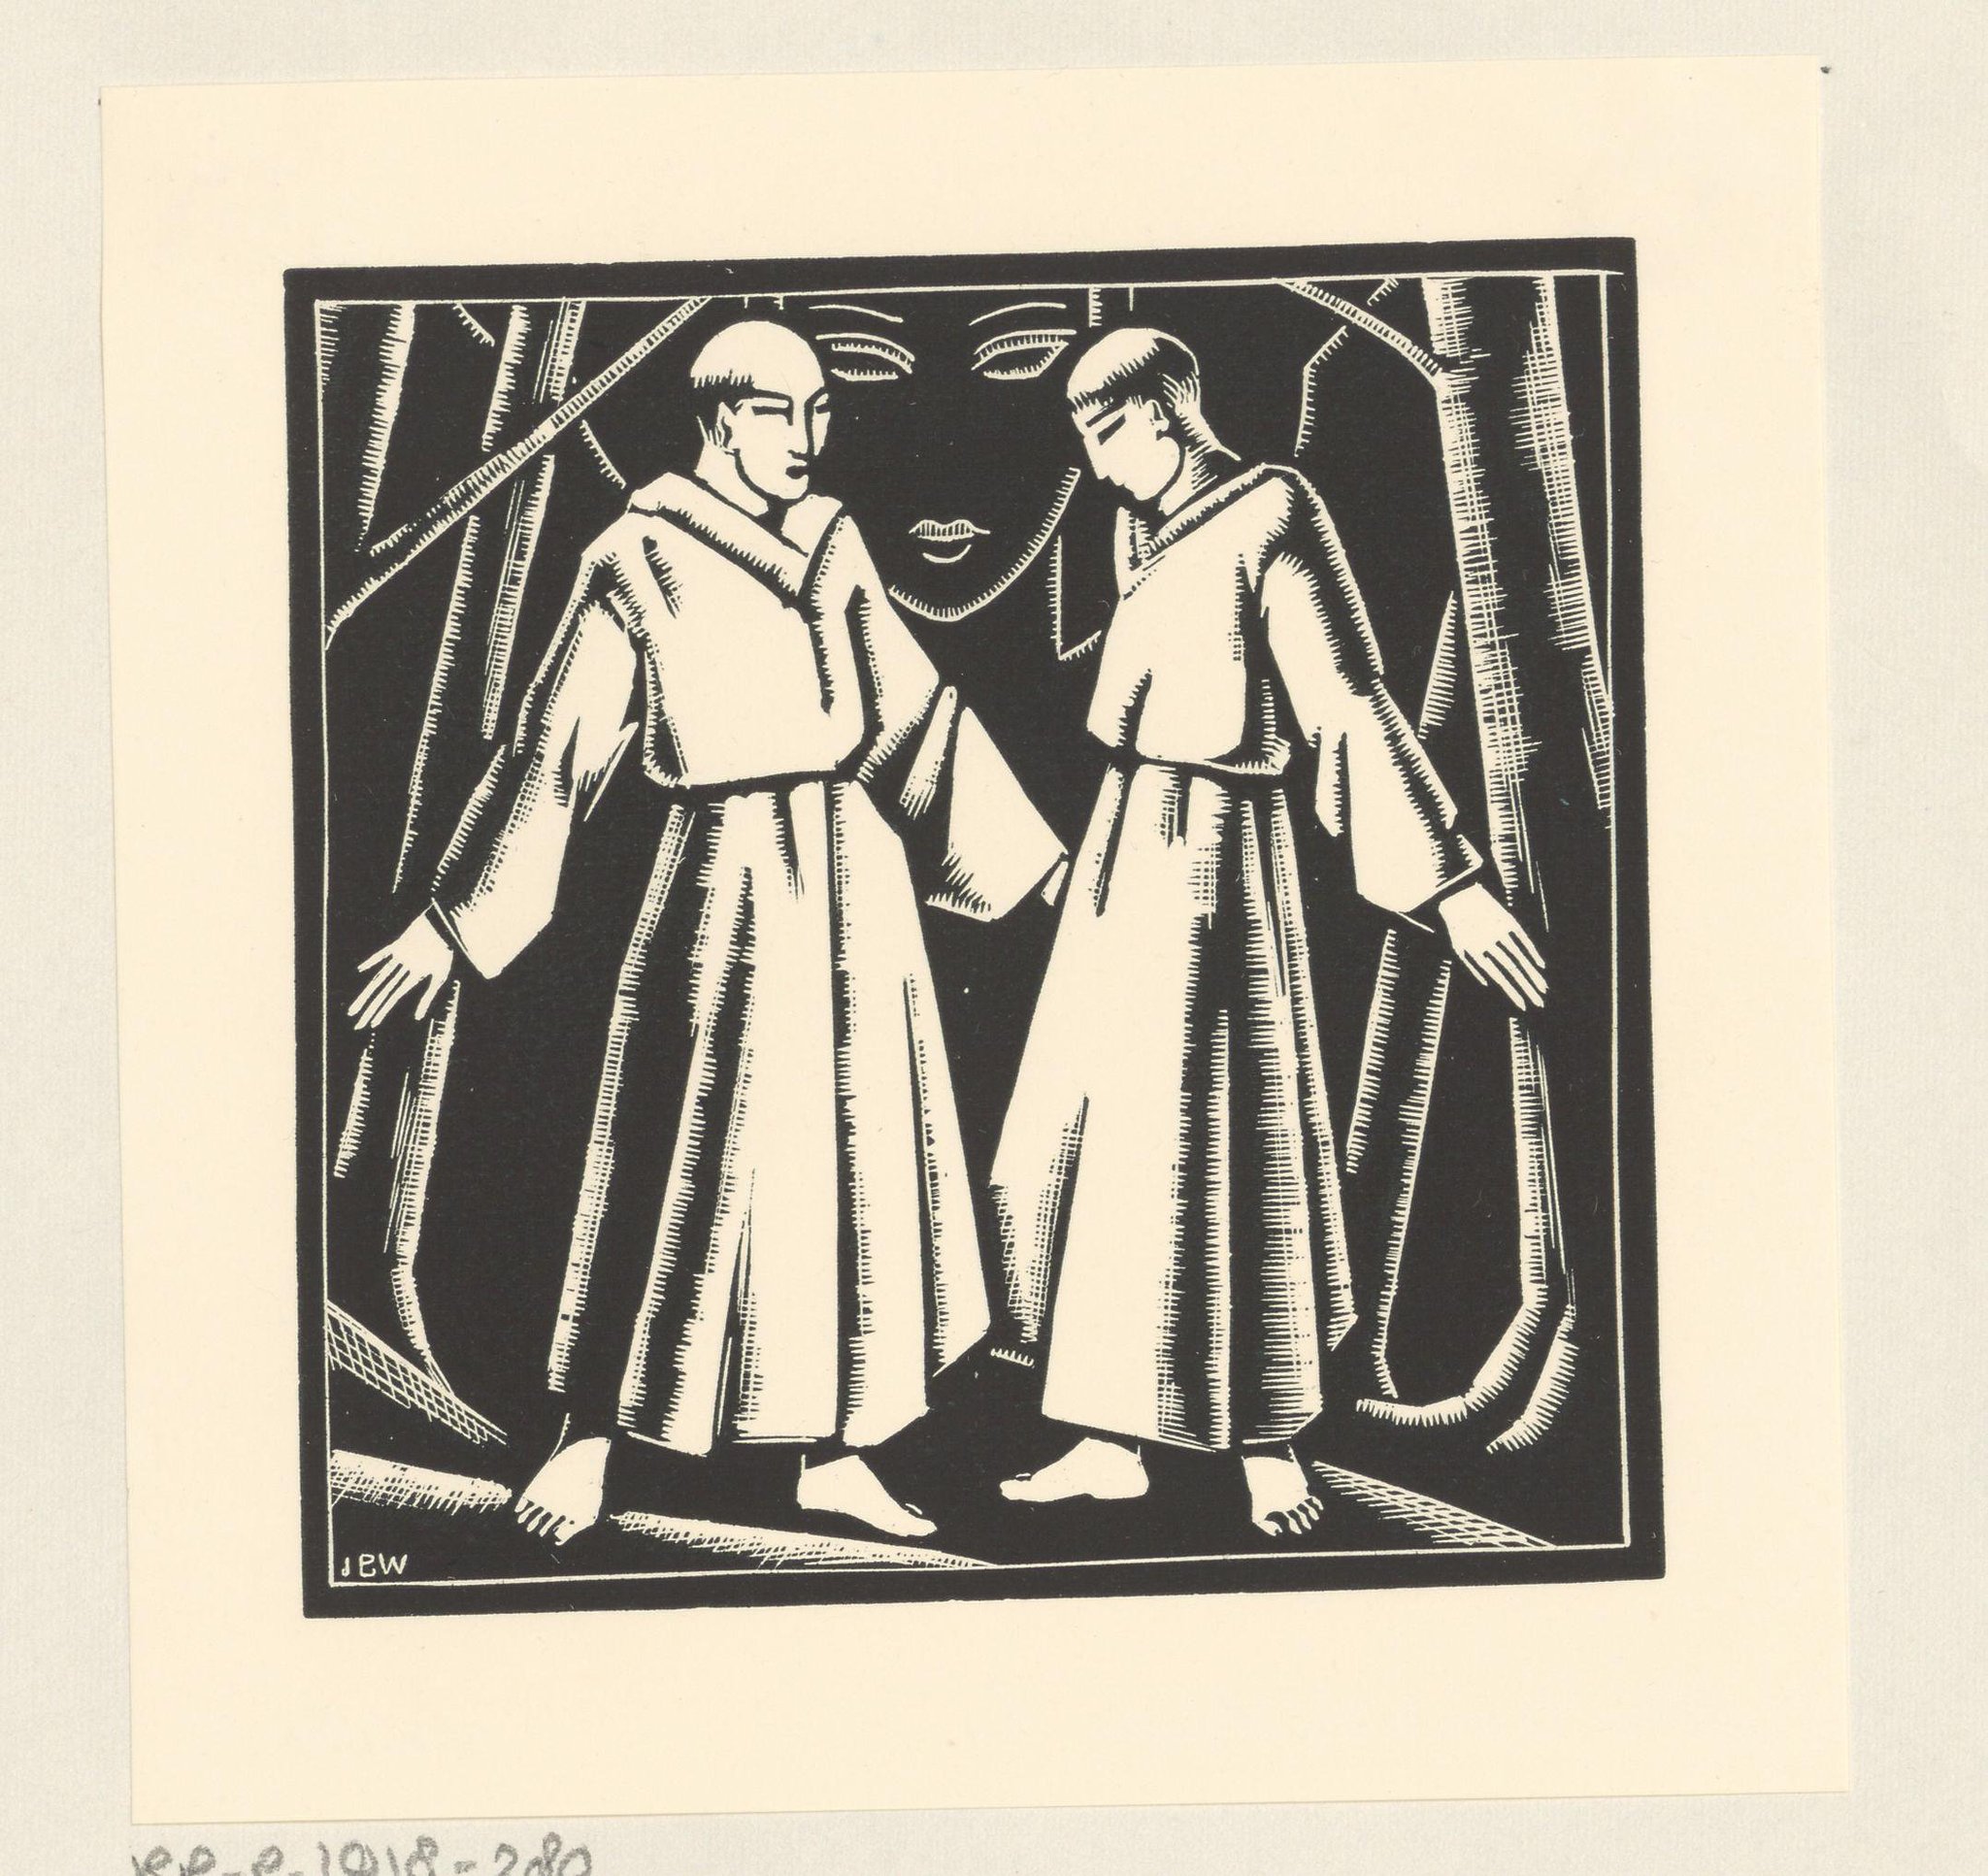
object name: book illustration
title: Twee monniken in een bos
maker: john buckland wright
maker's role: print maker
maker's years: 1897-1954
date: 1928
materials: paper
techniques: woodcut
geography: england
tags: face, standing figure, monk(s), friar(s), forest, wood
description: Prent bedoeld als illustratie voor een uitgave van Iwan Gilkin's "Le Sphinx" (1907). Deze publicatie werd echter niet gerealiseerd. Pas in 1960 verschenen zij als complete set van 14 afbeeldingen.